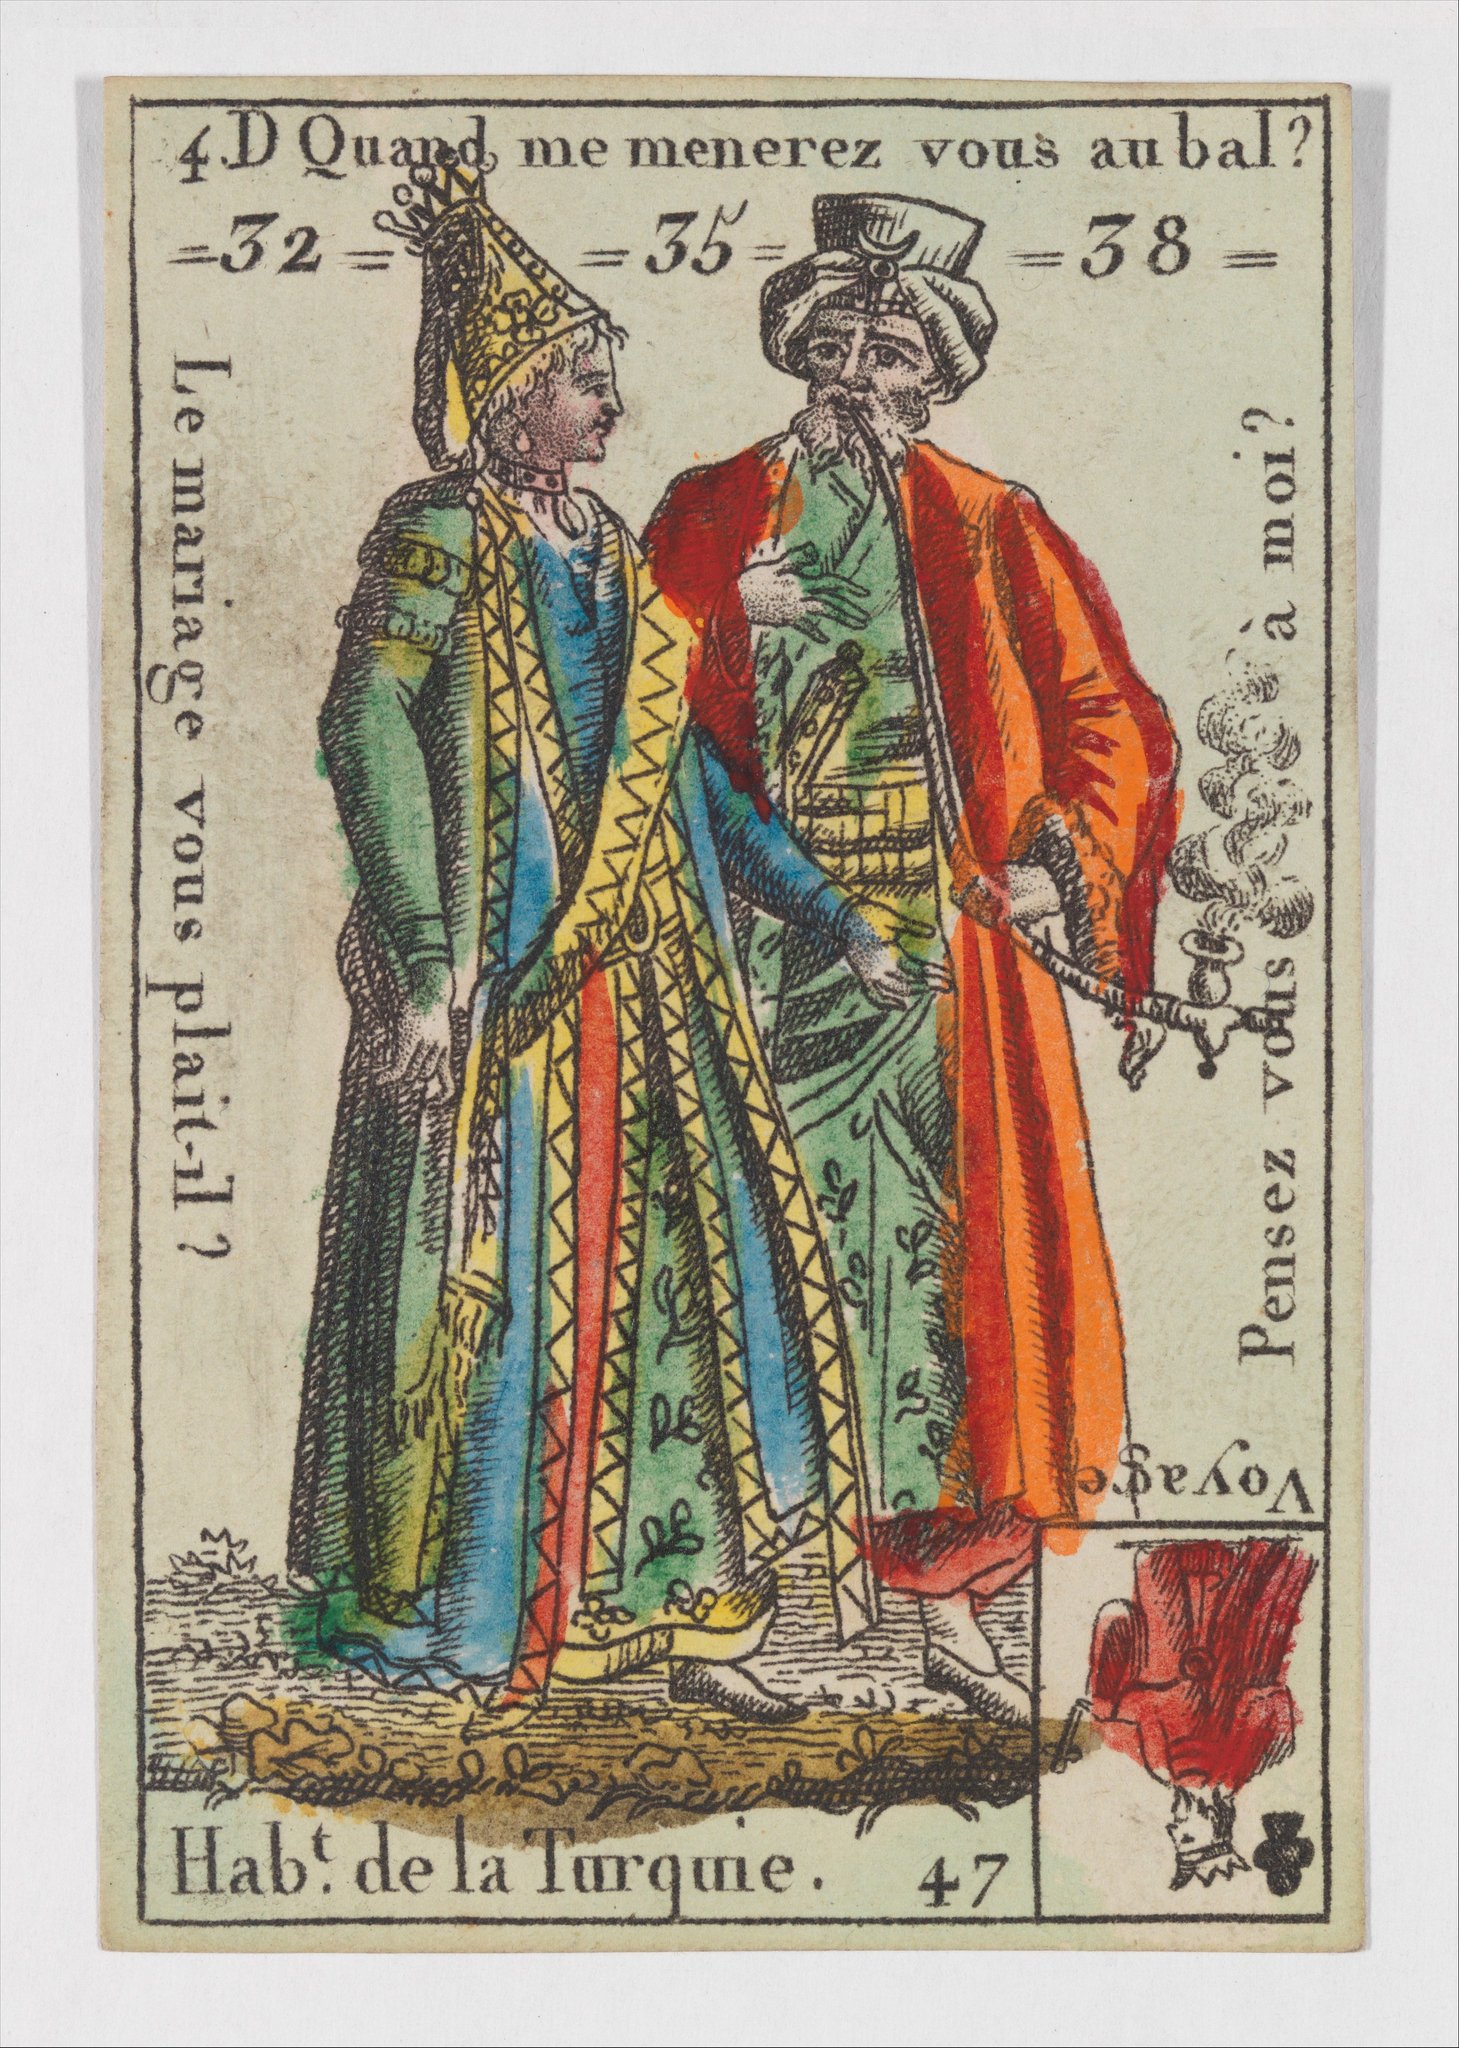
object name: print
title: Hab.t de la Turquie, from the playing cards (for quartets) "Costumes des Peuples Étrangers"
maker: anonymous, french, 18th century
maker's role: artist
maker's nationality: french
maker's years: 1700-1800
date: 1700-1799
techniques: etching, hand coloring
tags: men,profiles,women